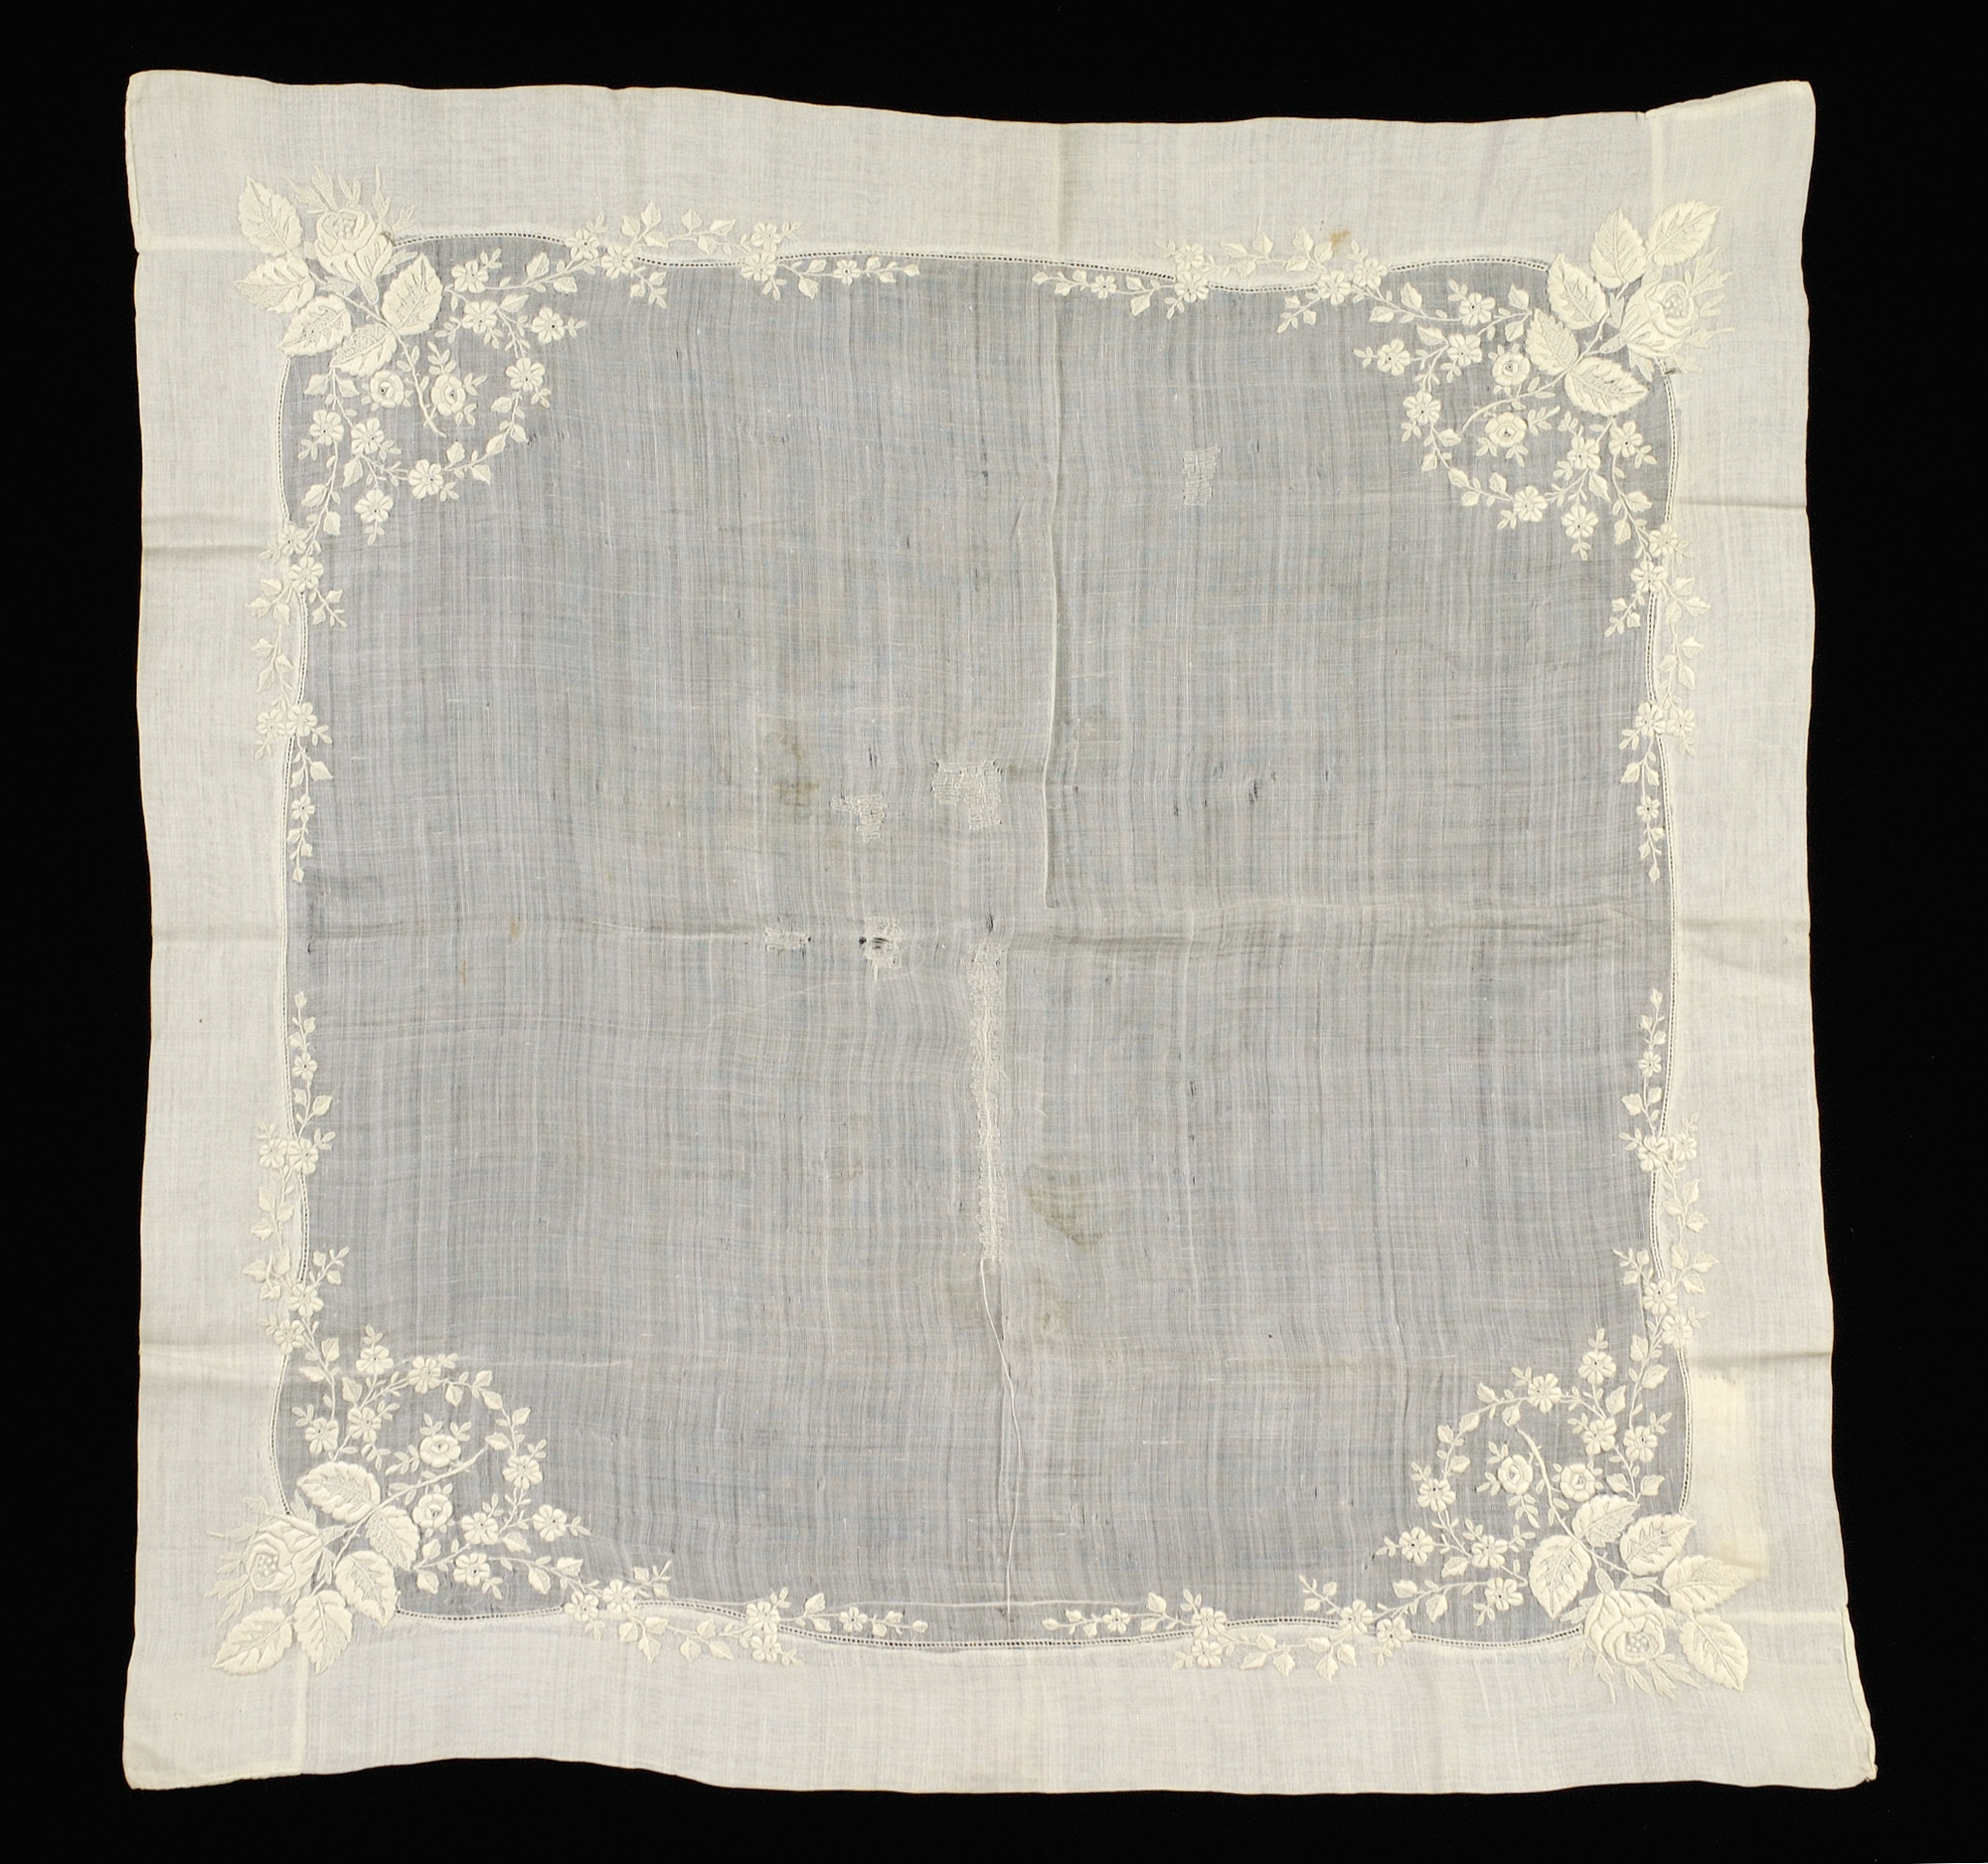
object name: handkerchief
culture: american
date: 1840-1860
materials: linen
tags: flowers